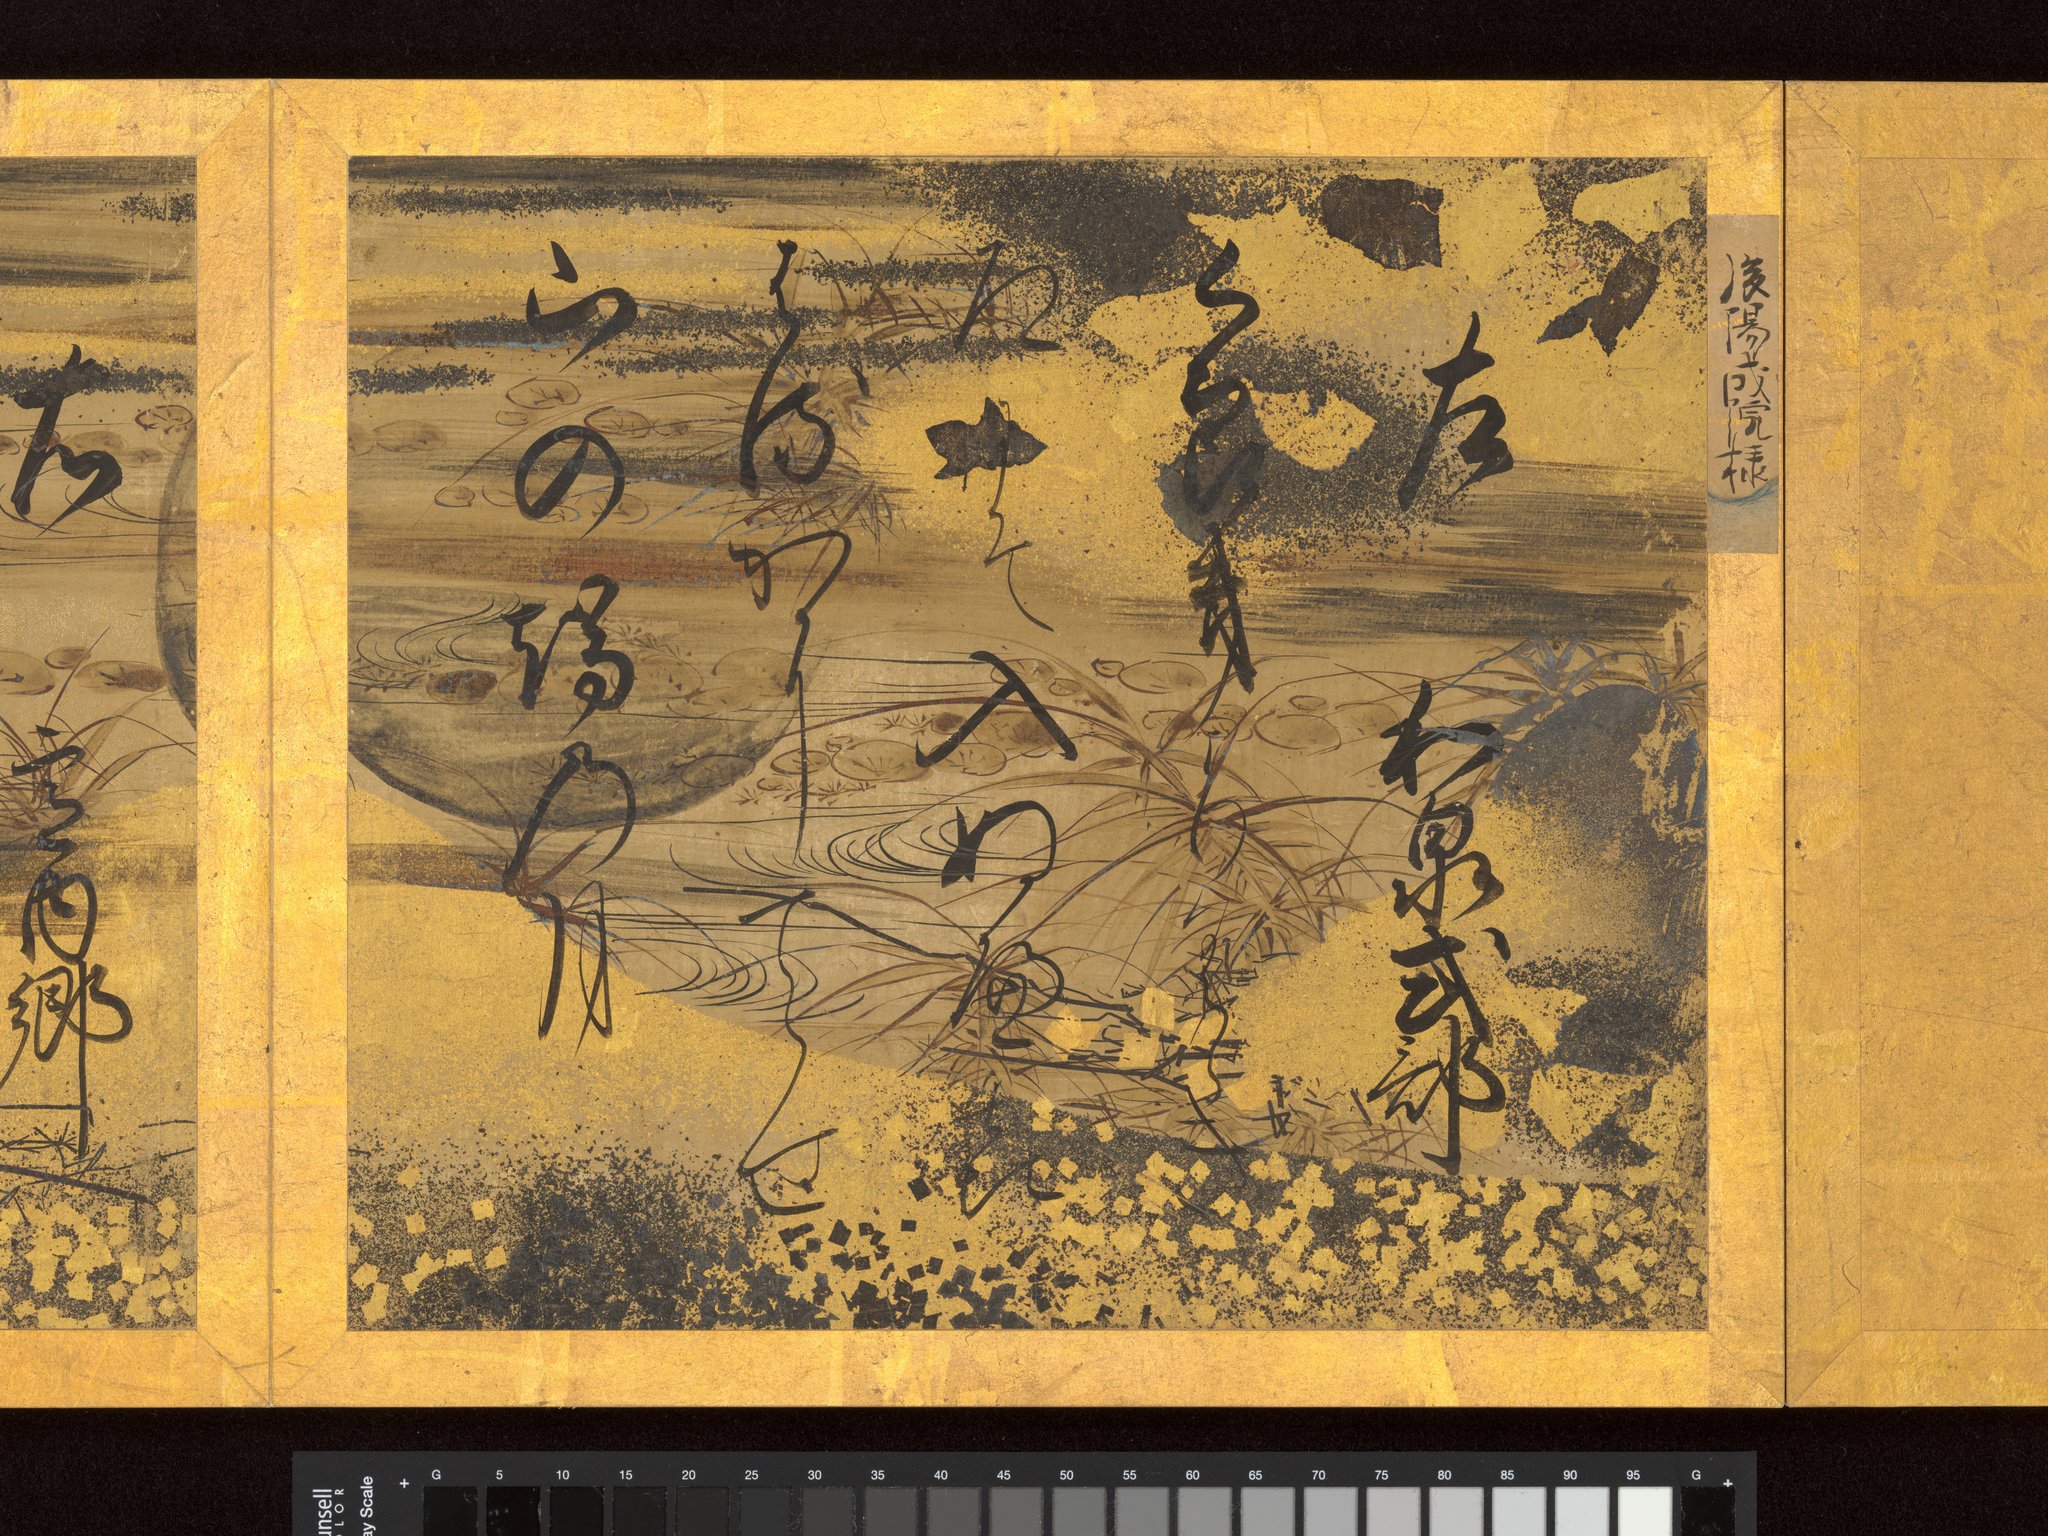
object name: album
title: Album of Twelve Waka from Poetry Competition of Poets of Different Eras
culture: japanese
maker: emperor go-yōzei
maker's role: artist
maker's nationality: japanese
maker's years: 1571-1617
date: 1601-1633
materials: gold, ink, paper, silver